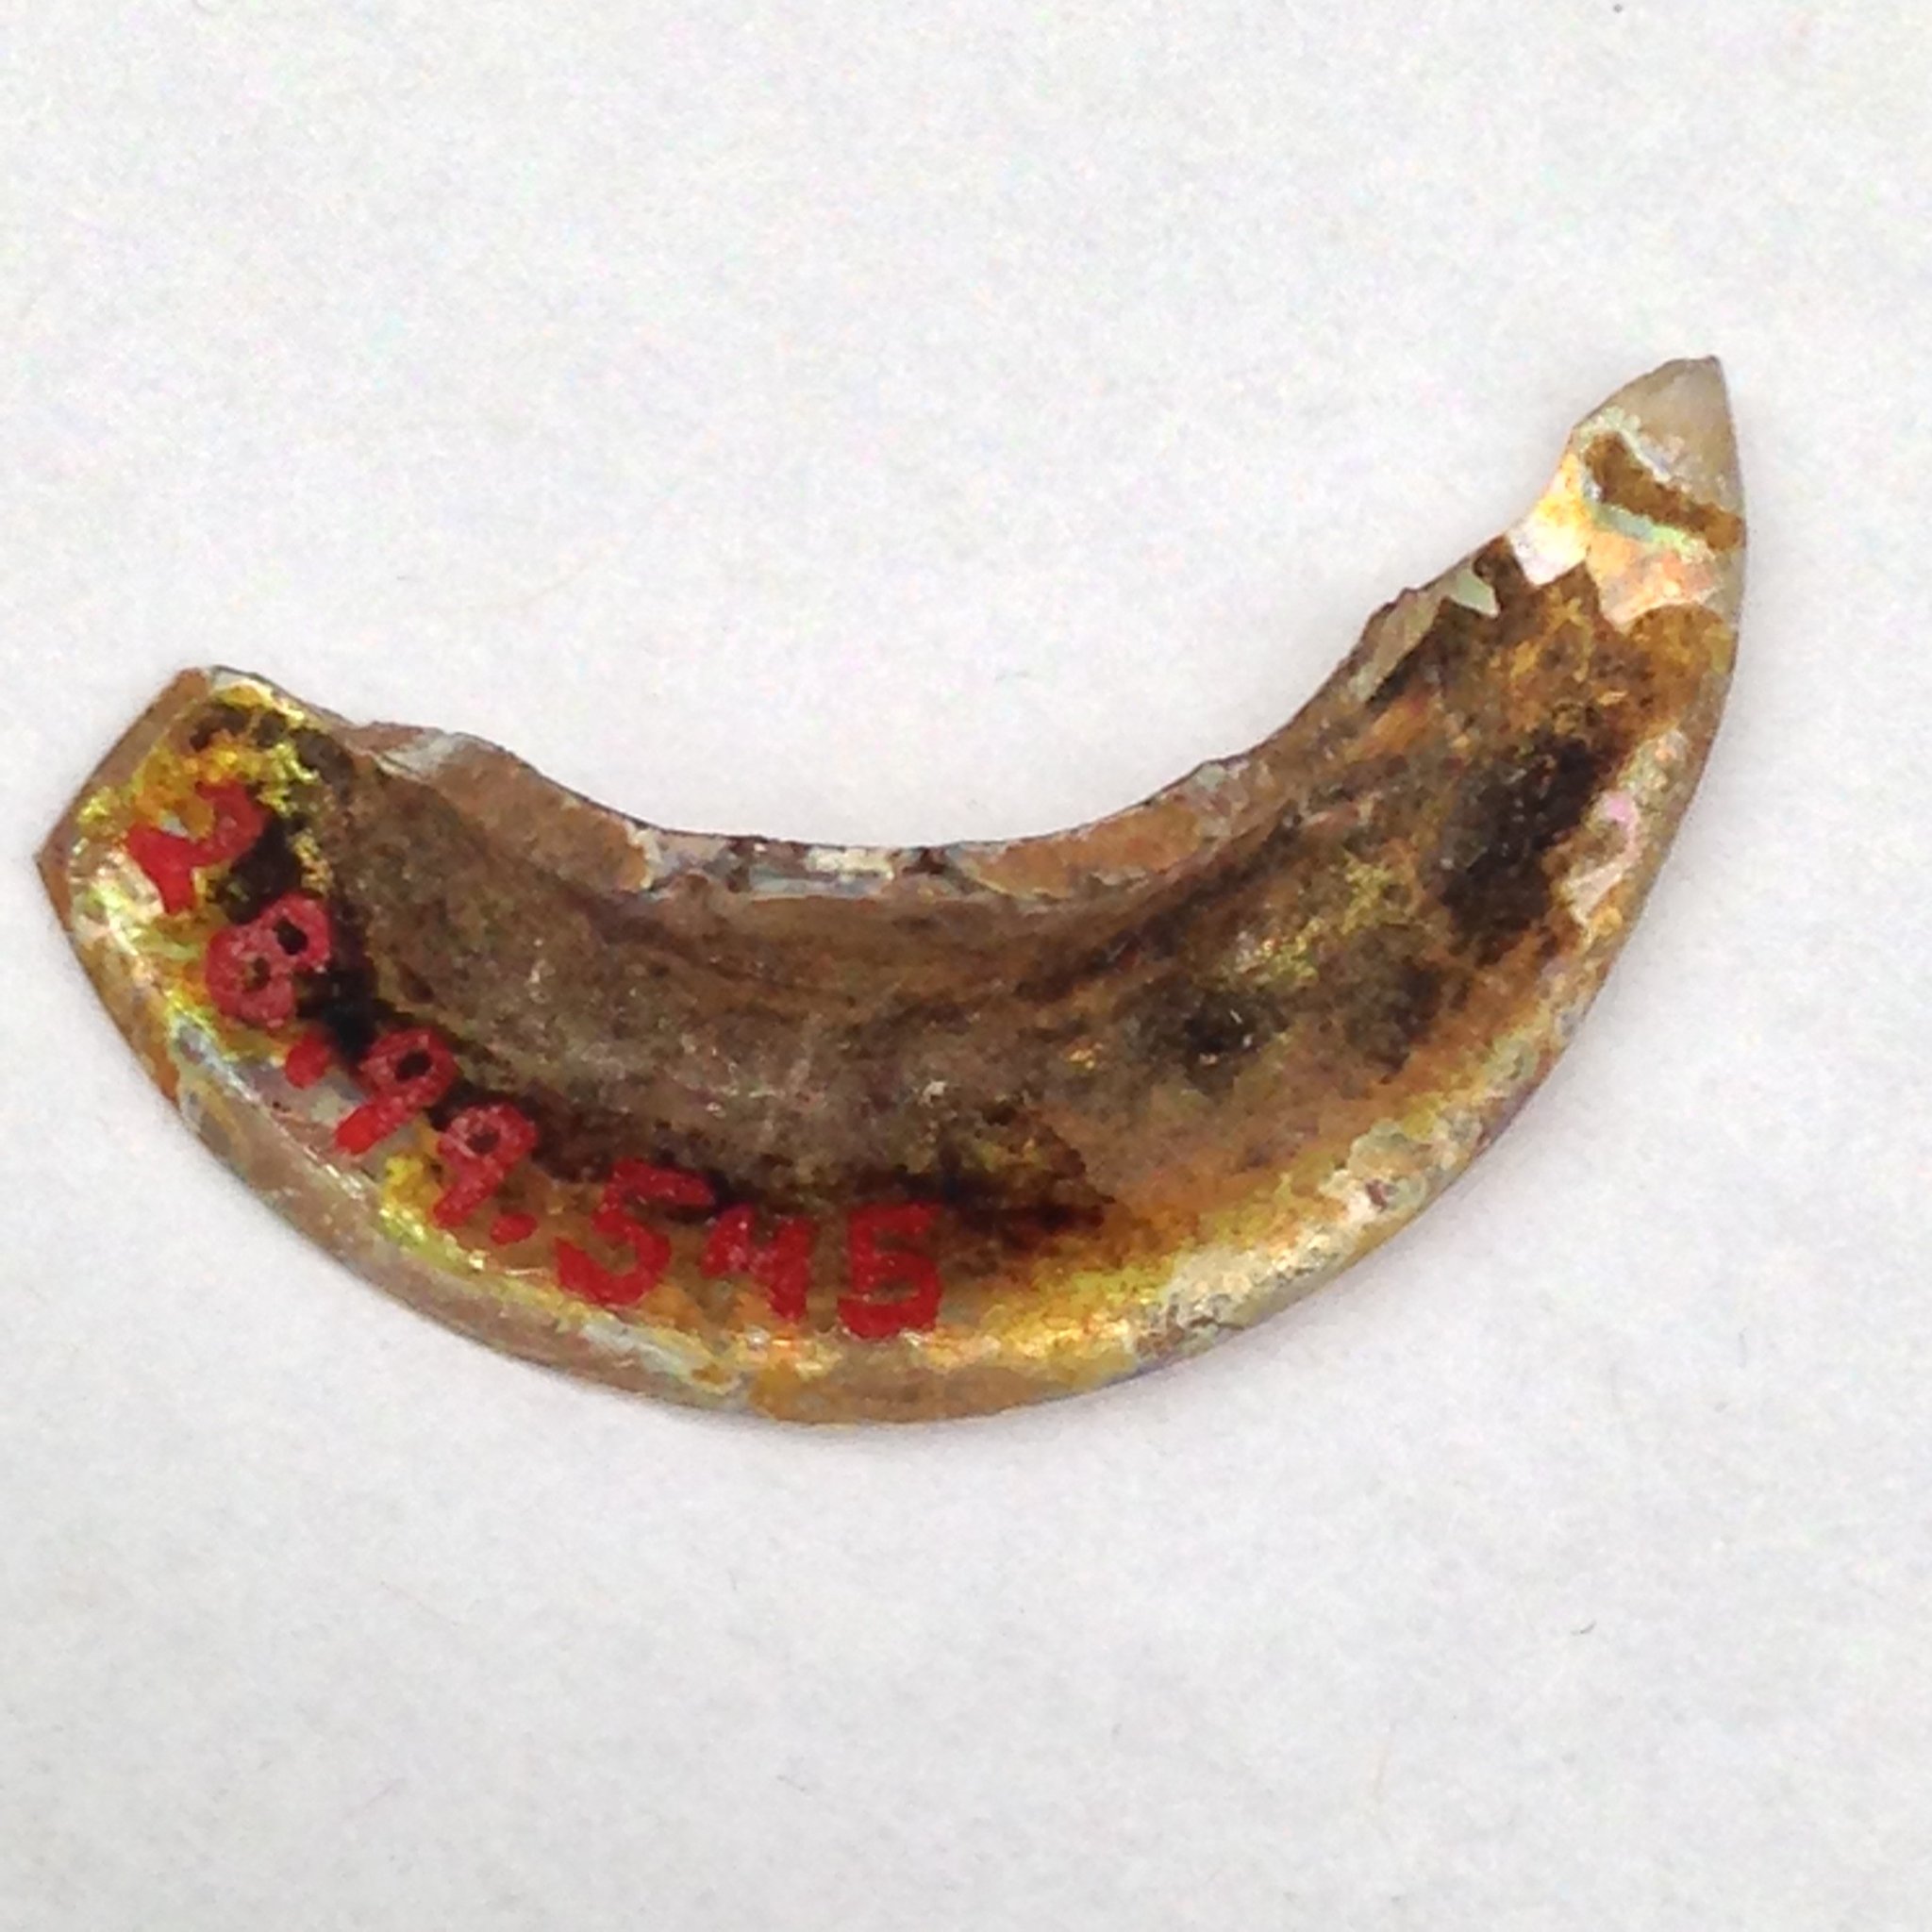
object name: fragment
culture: european or middle eastern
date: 1150-1250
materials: ceramic, glass